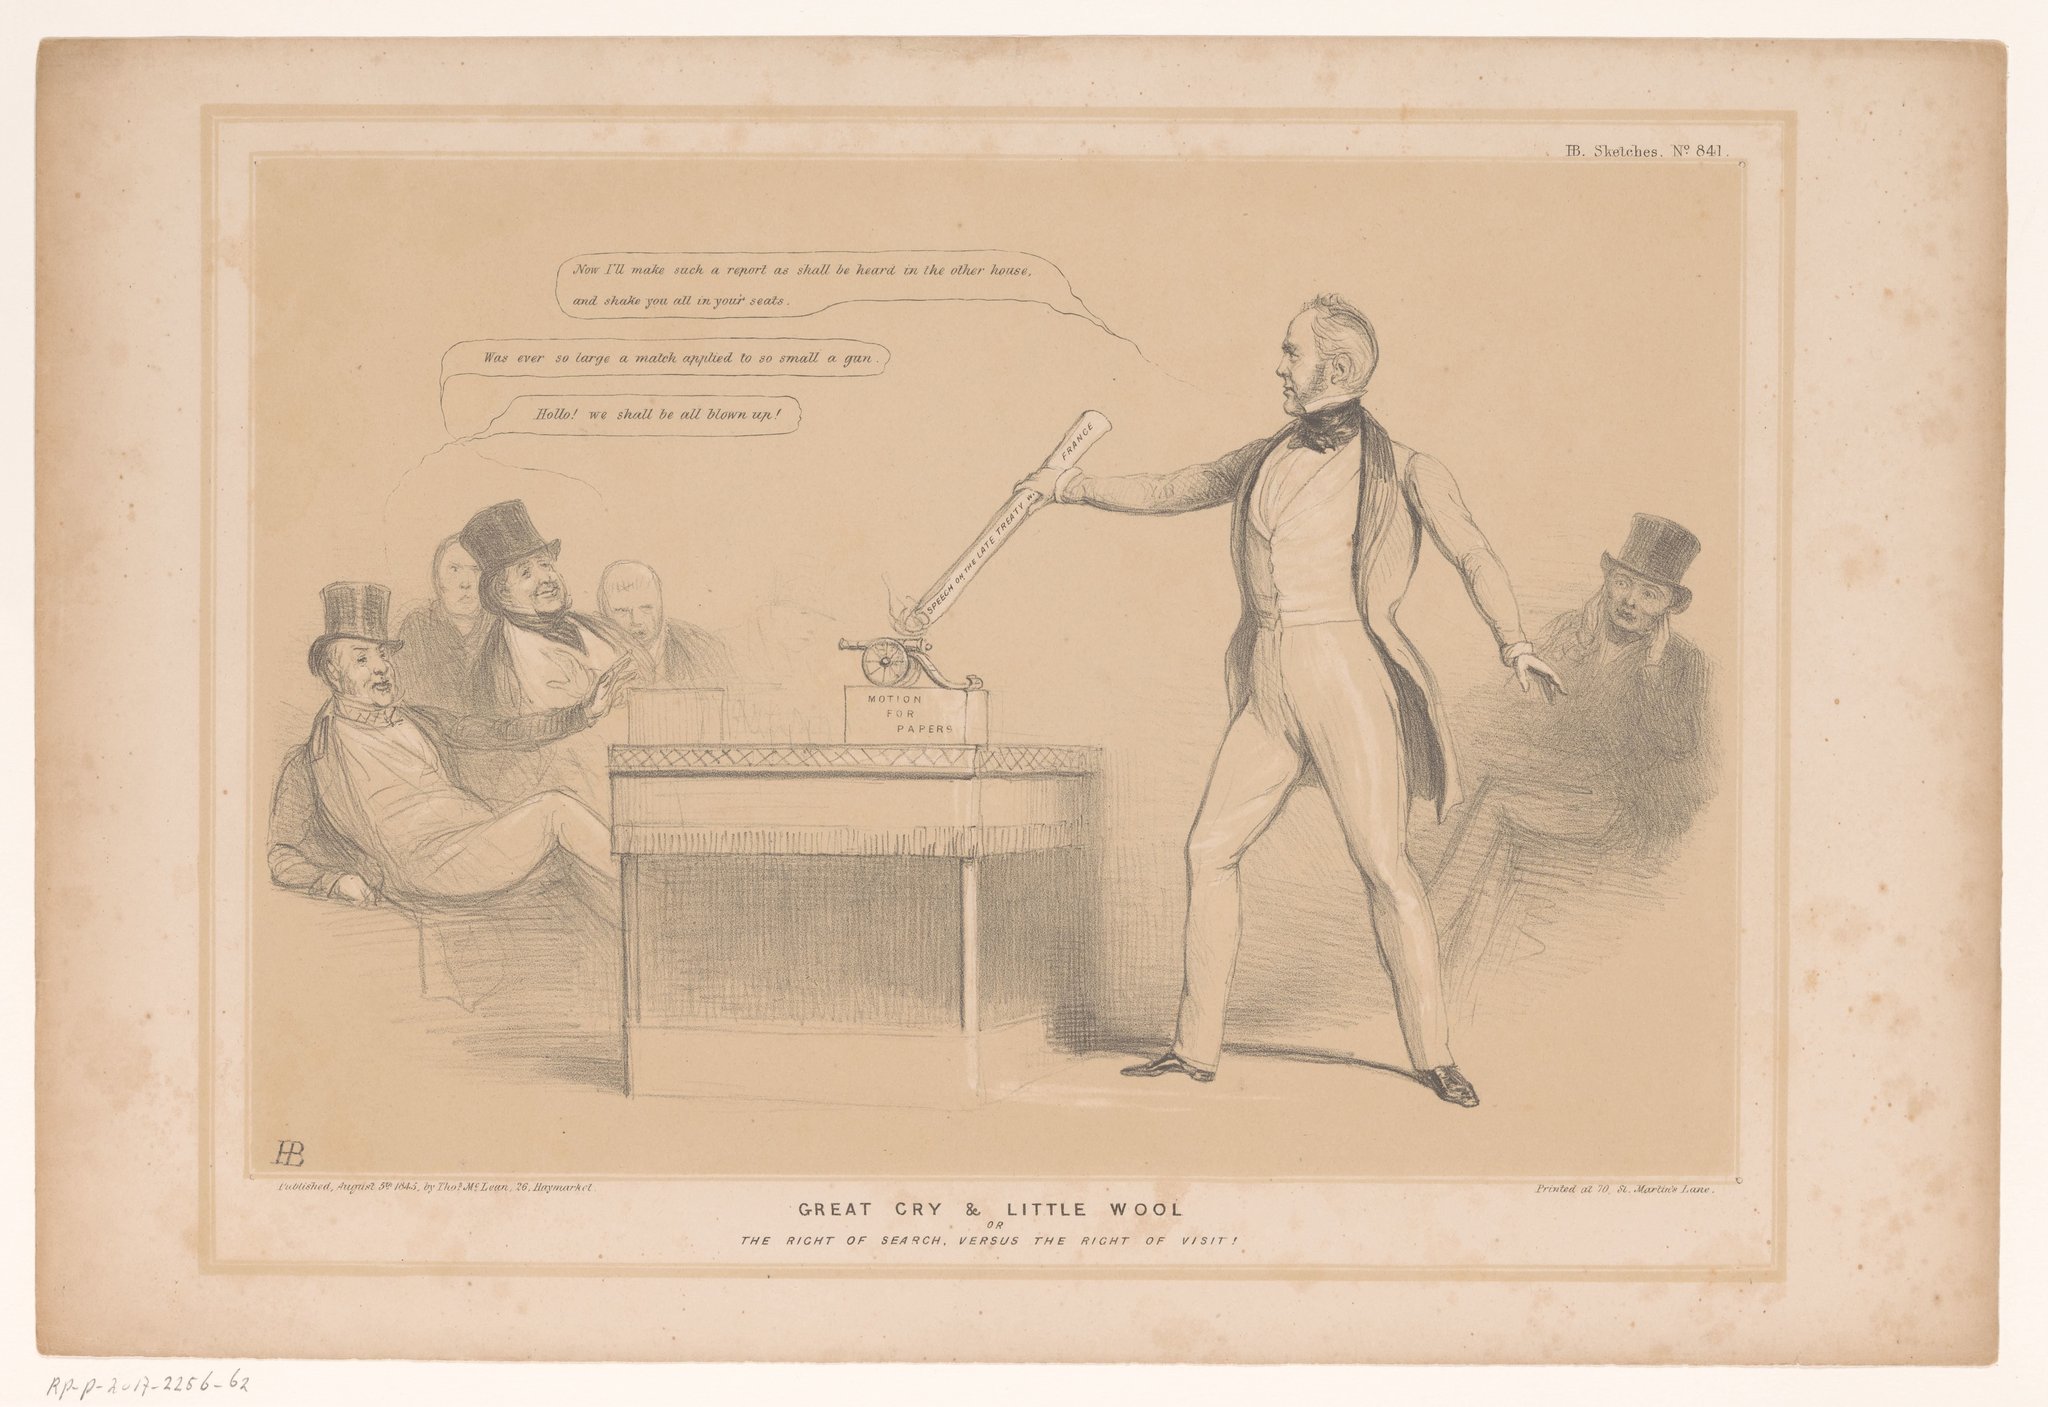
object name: cartoon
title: A great cry and little wool or The right of search, versus the right of visit!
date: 1845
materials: paper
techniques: tone lithography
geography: london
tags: match, firearms: cannon, political caricatures and satires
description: Spotprent uit 1845 met Lord Palmerston die met een enorme lucifer de lont van een zeer klein kanon aansteekt. Uitgegeven als nr. 841 in de serie HB Sketches.